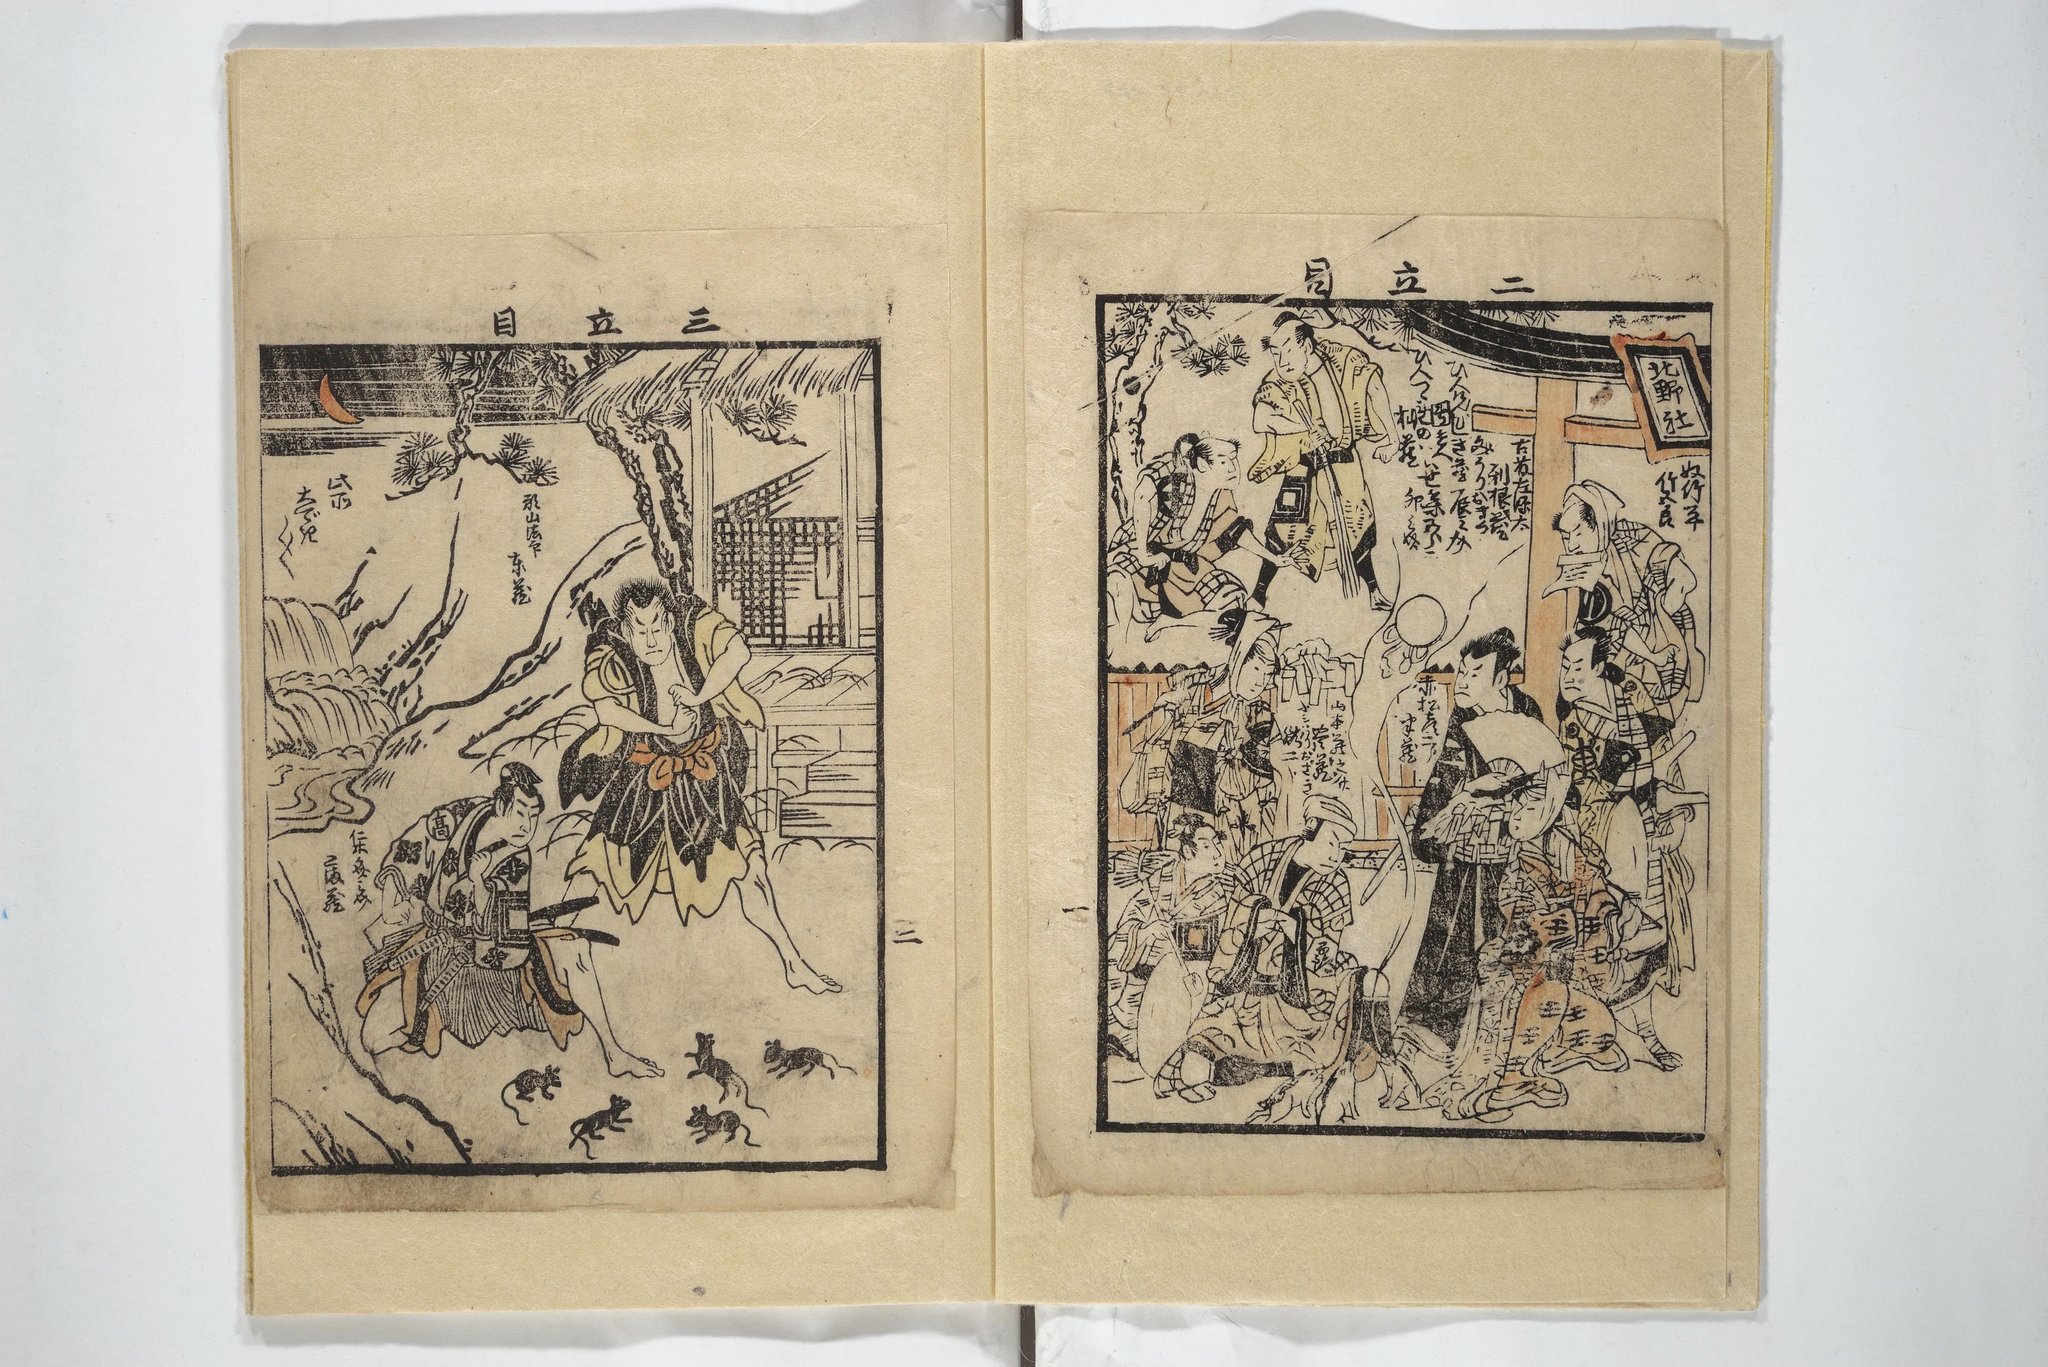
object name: illustrated book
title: Picture Book with Synopses of Plays (Ehon banzuke) for Performances at the Nakamura Theater in 1794 絵本番付; 大三浦達寿(おうみうら だて ねびき); 敵討染分手綱(かたきうち そめわけ たずな)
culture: japanese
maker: unidentified artist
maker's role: artist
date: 1799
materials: ink, paper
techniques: hand coloring, woodblock print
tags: theatre,actors